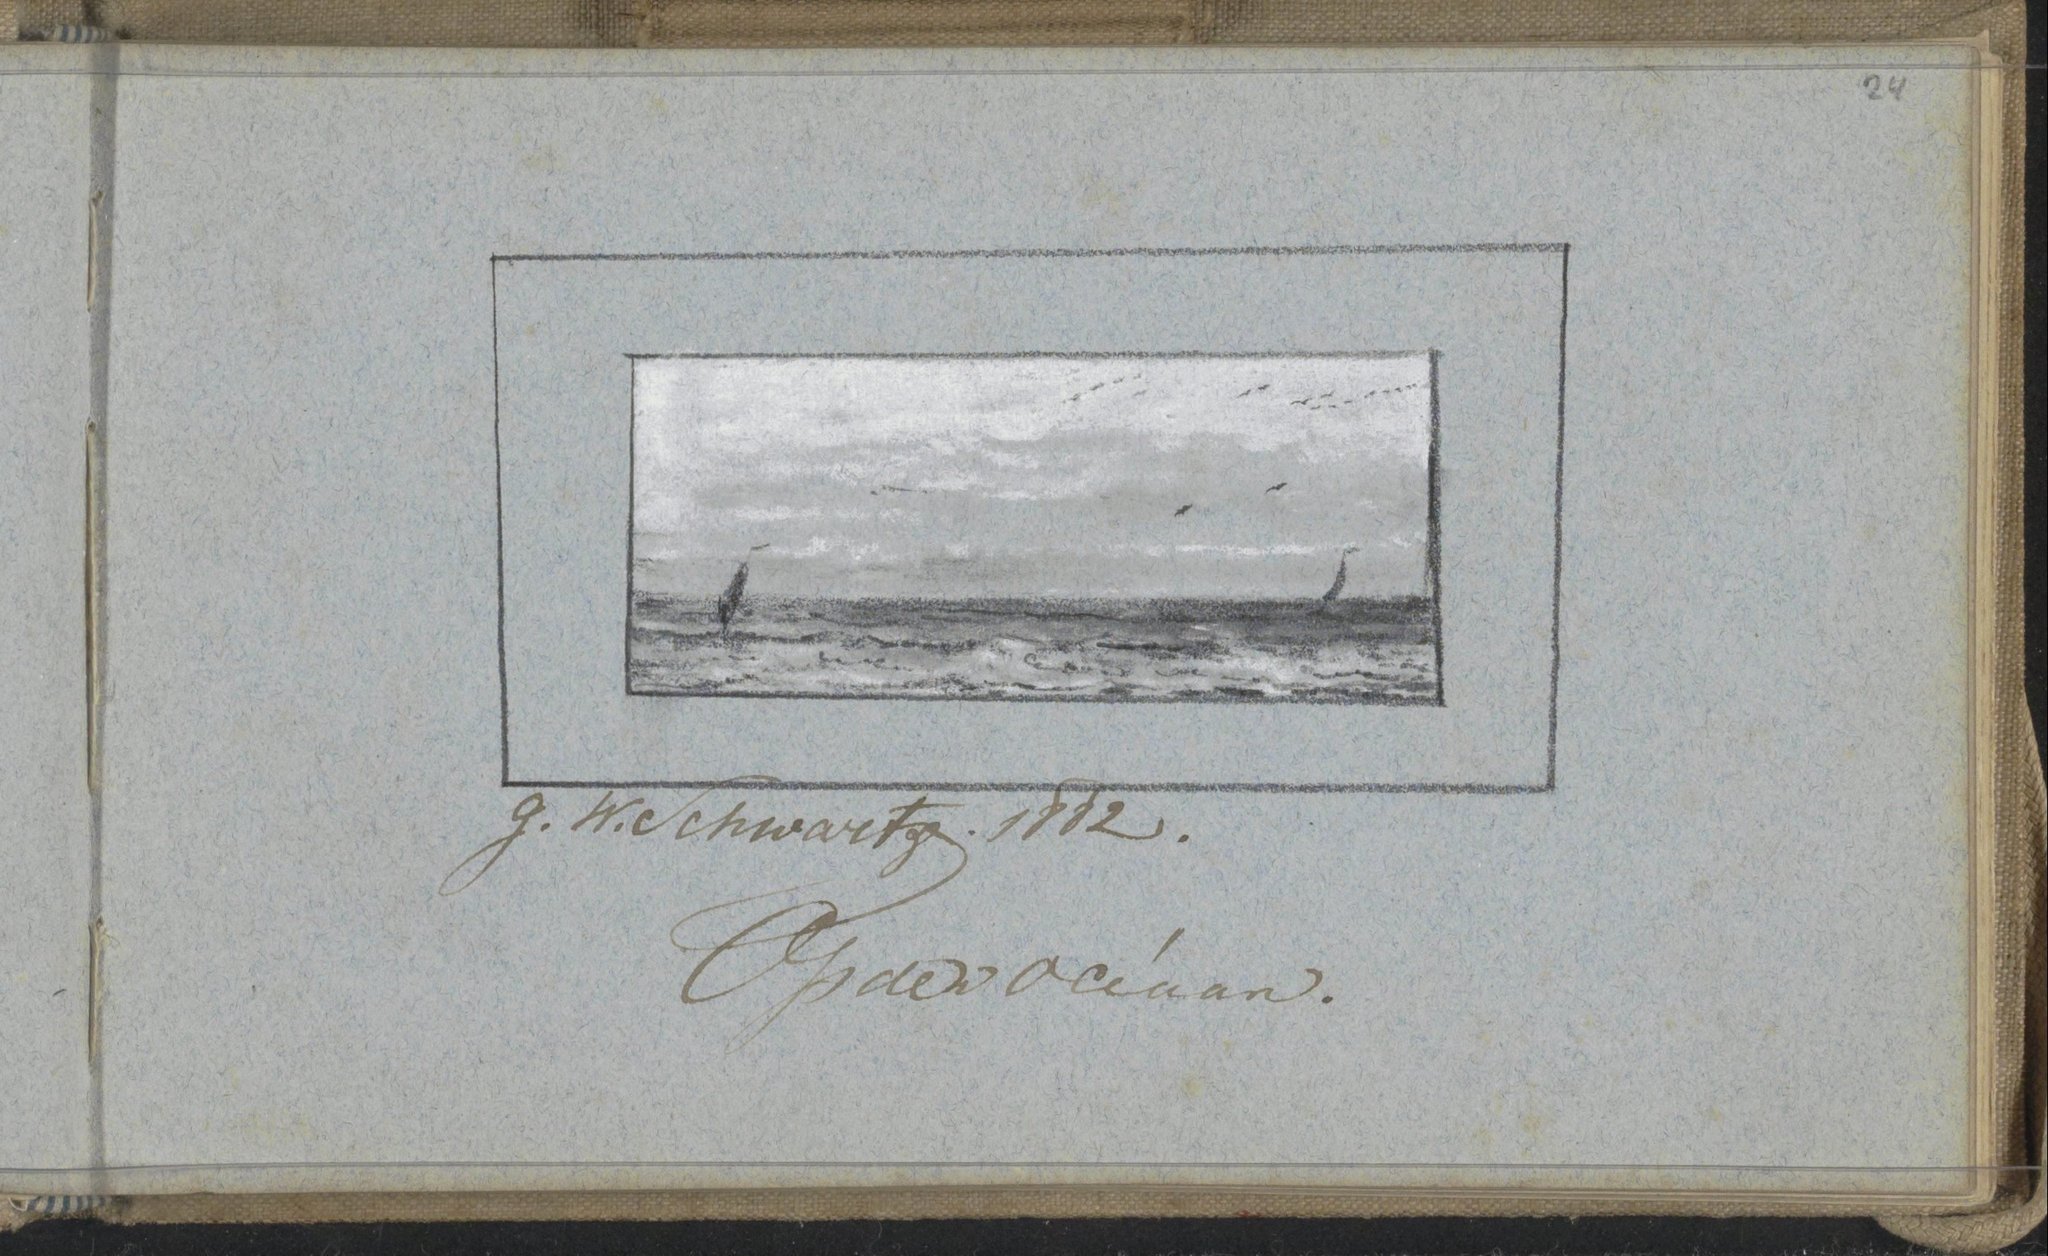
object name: sketchbook leaf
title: Schepen op de oceaan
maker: george washington schwartze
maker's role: draughtsman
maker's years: 1857-1909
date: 1882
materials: chalk, paper, pencil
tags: sailing-ship, sailing-boat, ocean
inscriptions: title: ‘Op den Océaan.’, signature and date: ‘G.W.Schwartze. 1882.’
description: Tekening in een dubbel kader. Blad 24 recto uit een schetsboek met 54 bladen.